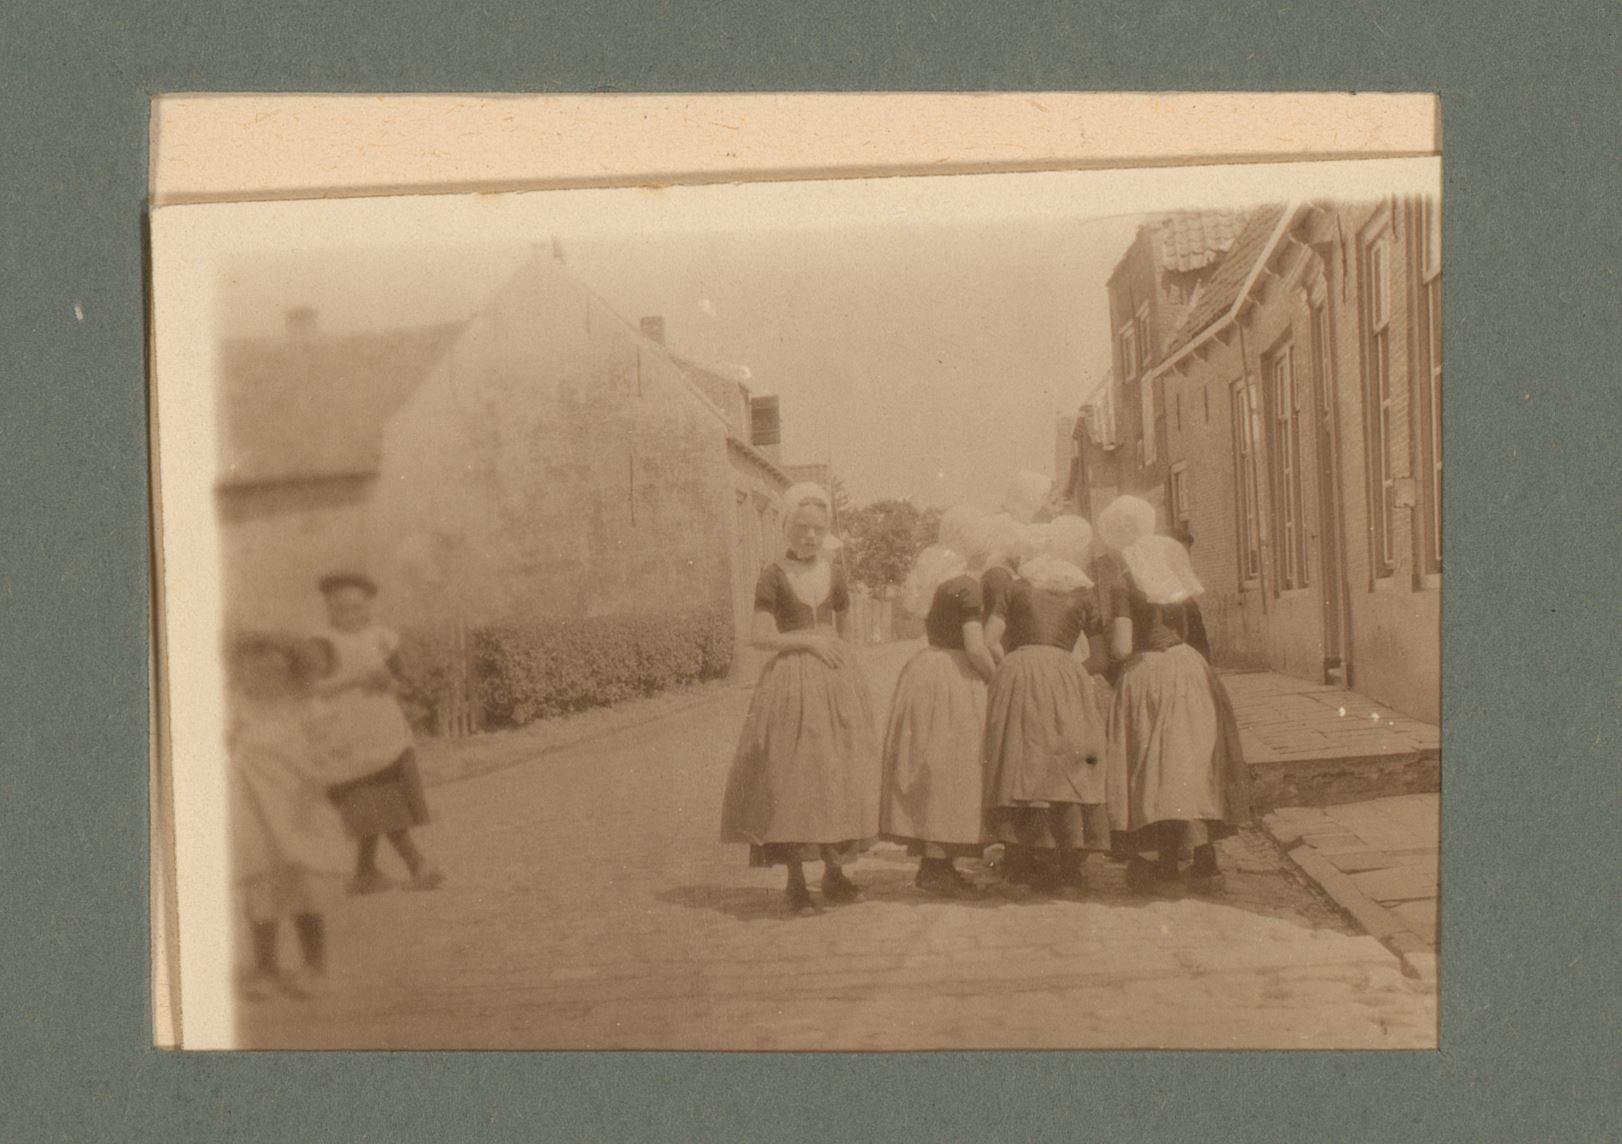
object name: photograph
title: Meisjes in klederdracht op straat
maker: george hidderley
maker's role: fotograaf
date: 1920-1940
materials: photographic support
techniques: daylight paper print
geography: netherlands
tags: historical persons, girl (child between toddler and youth), folk costume, regional costume